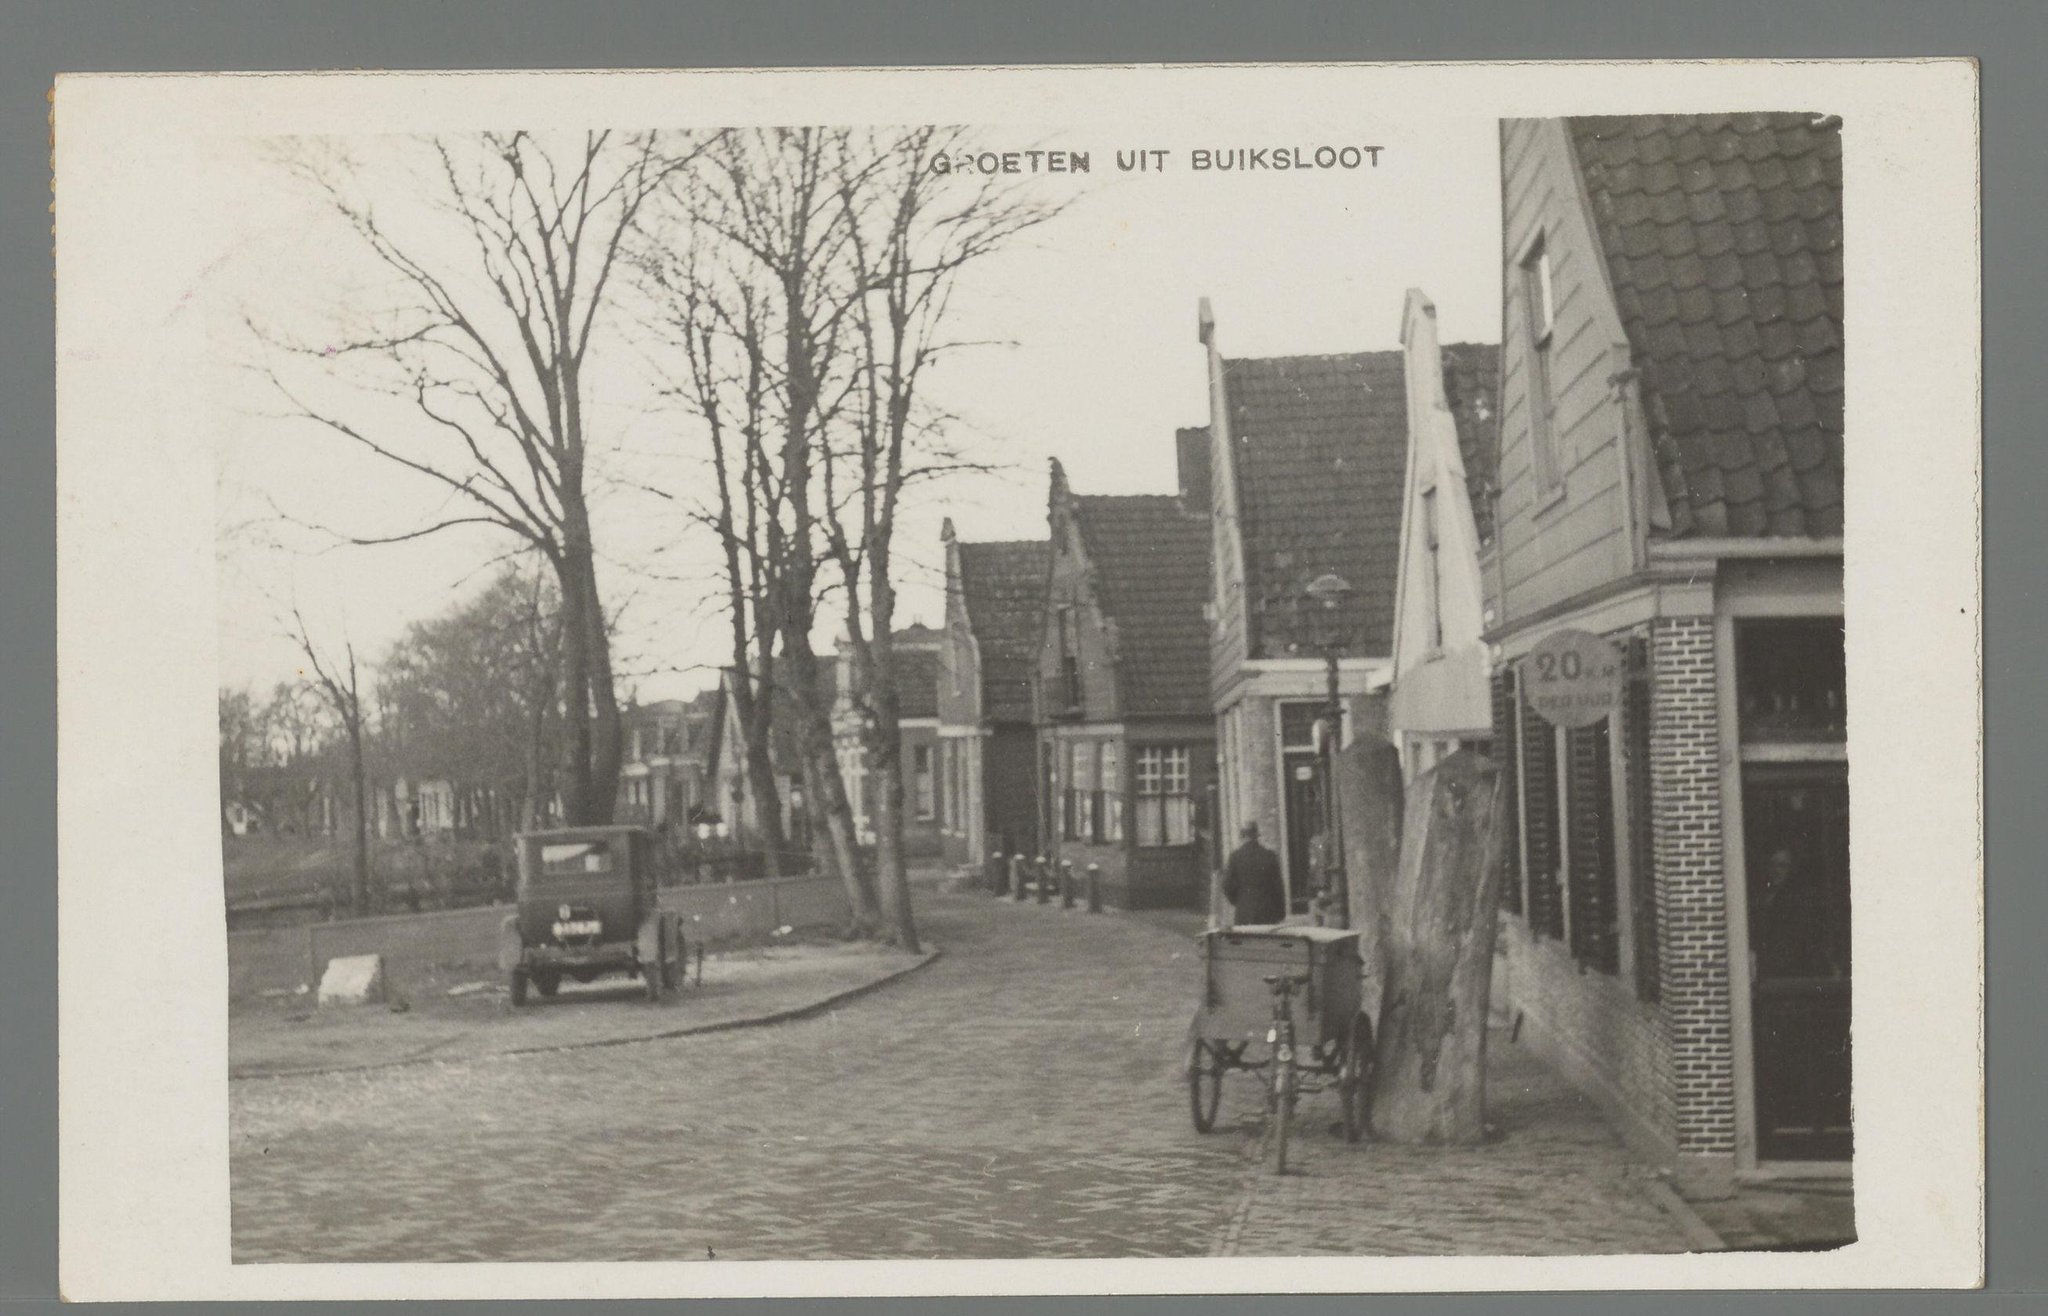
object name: photograph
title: GROETEN UIT BUIKSLOOT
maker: Anonymous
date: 1913-1930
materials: photographic support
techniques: photography, writing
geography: buiksloot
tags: city-view, and landscape with man-made constructions, automobile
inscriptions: postage stamp